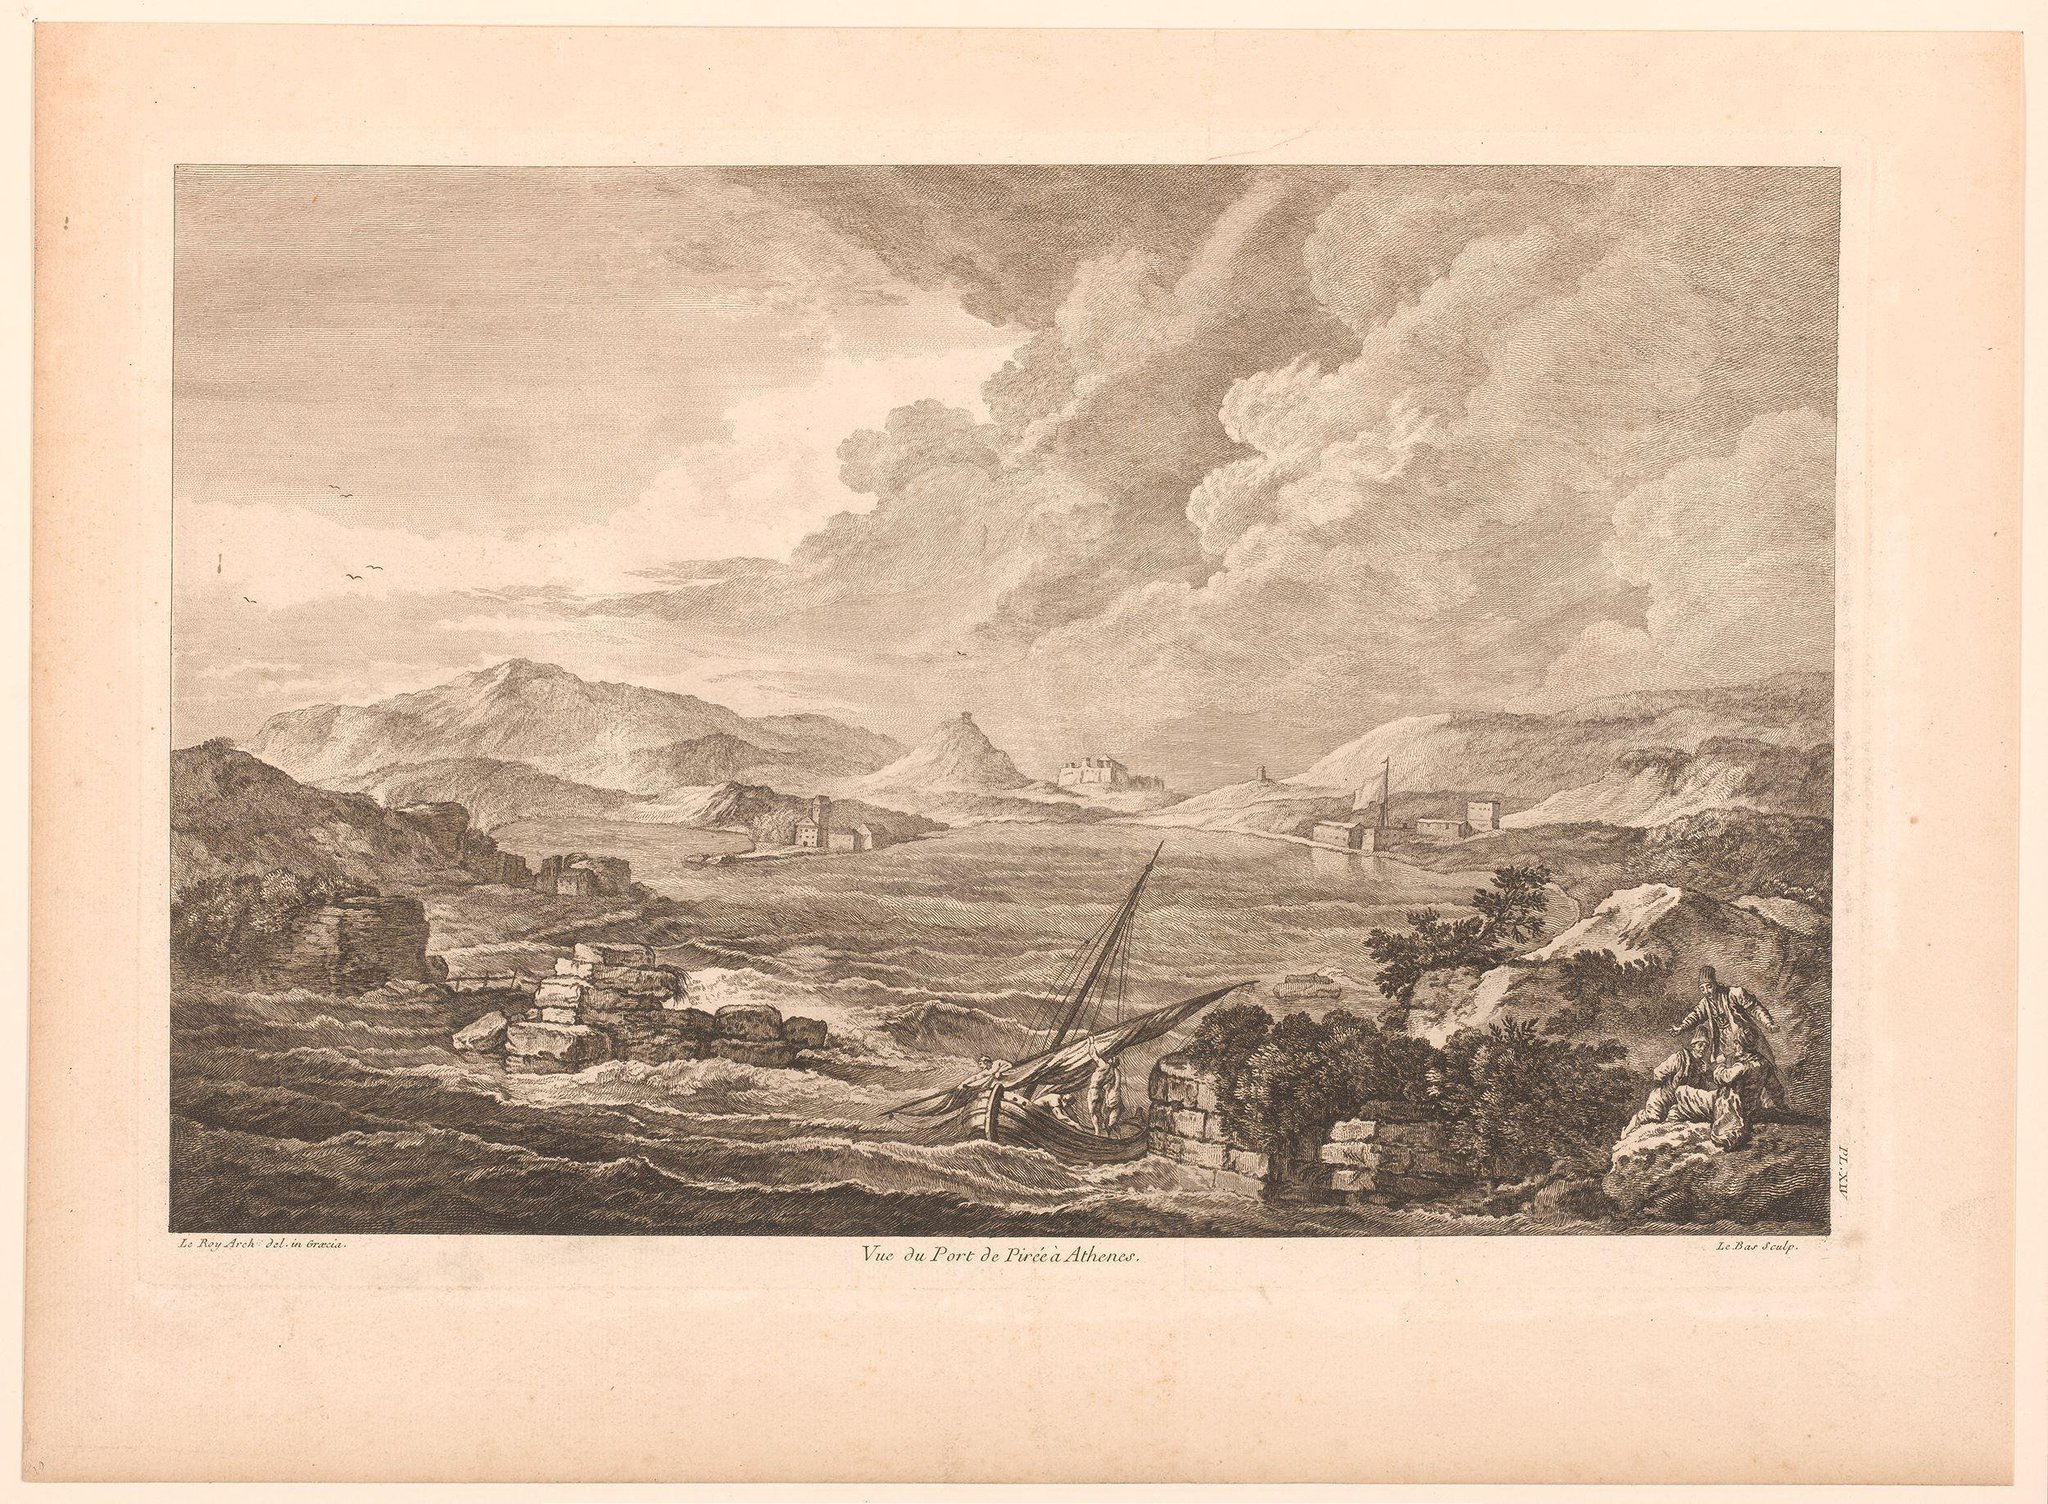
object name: book illustration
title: Gezicht op Pireus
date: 1758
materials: paper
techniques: etching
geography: greece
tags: harbour, ruin of a building ~ architecture, landscape with ruins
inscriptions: collector's mark: Lugt 2228, collector's mark: Lugt 2760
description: Prent uit: Le Roy, Julien. Ruines des plus beaux monuments de la Grêce. Parijs: Guérin & de La Tour, 1758. Dit betreft plaat XIV.